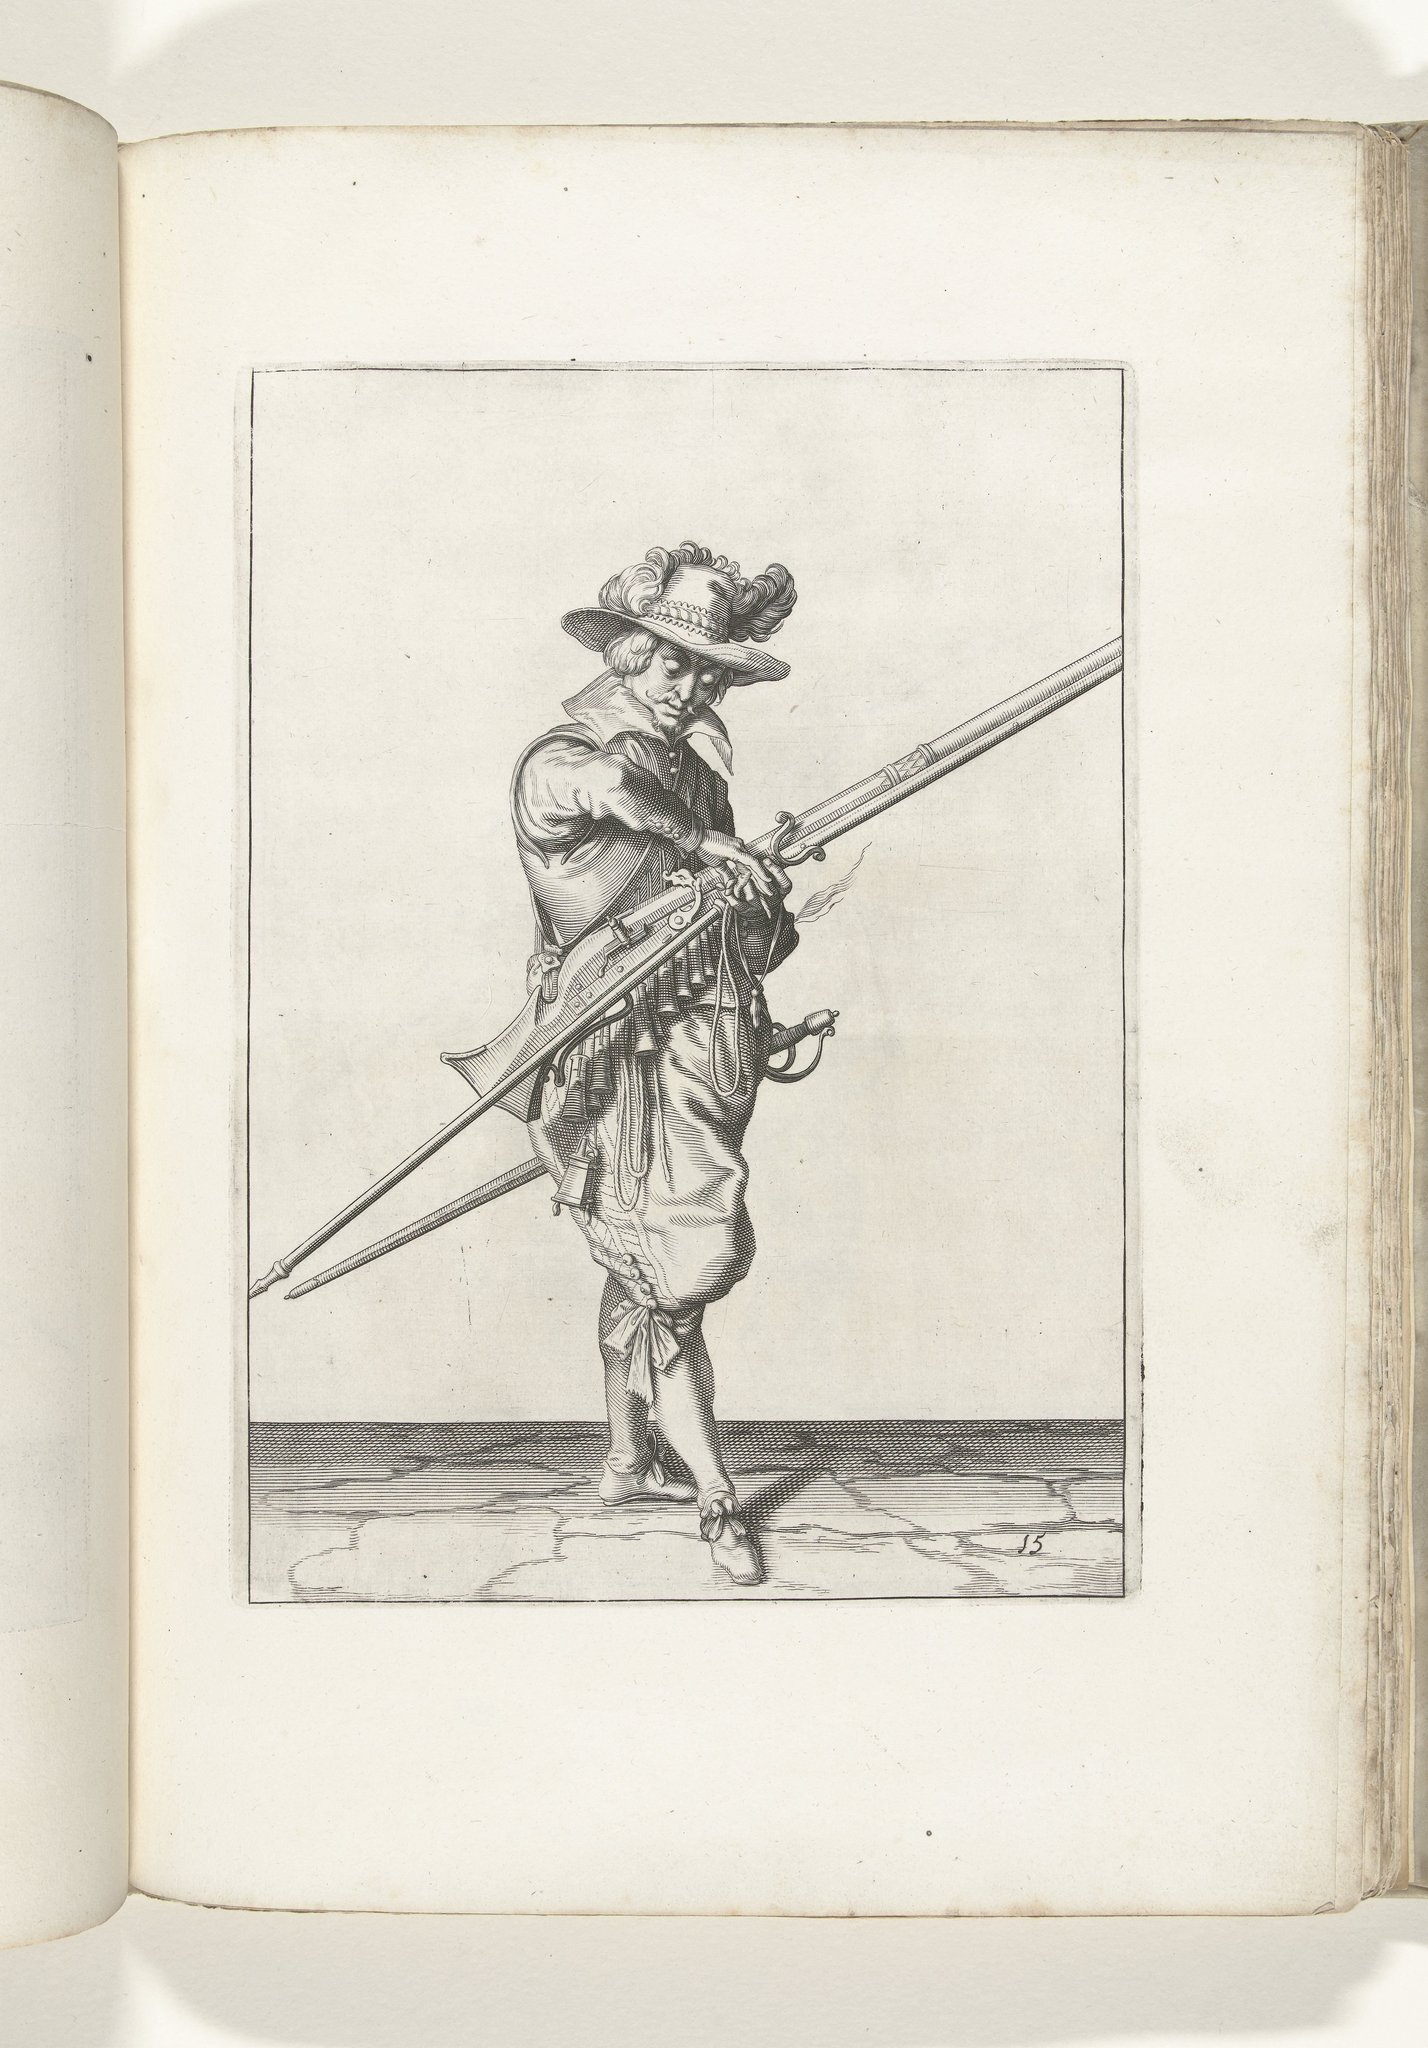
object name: print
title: Soldaat met een musket die zijn lont overbrengt van zijn rechter- naar zijn linkerhand (nr. 15), ca. 1600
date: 1597-1607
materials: paper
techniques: engraving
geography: the hague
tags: the hague, maurice (prince of orange), handling of weapons ~ military training, weapons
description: Een soldaat, ten voeten uit, naar rechts, die een musket (een bepaald type vuurwapen) en een furket (musketvork) met zijn linkerhand vasthoudt (nr. 15), ca. 1600. De brandende lont in zijn rechterhand brengt hij over naar zijn linkerhand. Plaat 15 in de instructies voor het hanteren van het musket: Corte onderrechtinghe op de figuerliicke afbeeldinghe, soo veel aengaet het recht ghebruyck vant Musquet. Onderdeel van de illustraties in: J. de Gheyn, Wapenhandelinghe van Roers Musquetten ende spiessen, 's-Gravenhage, 1607. Krijgswezen rond 1600.